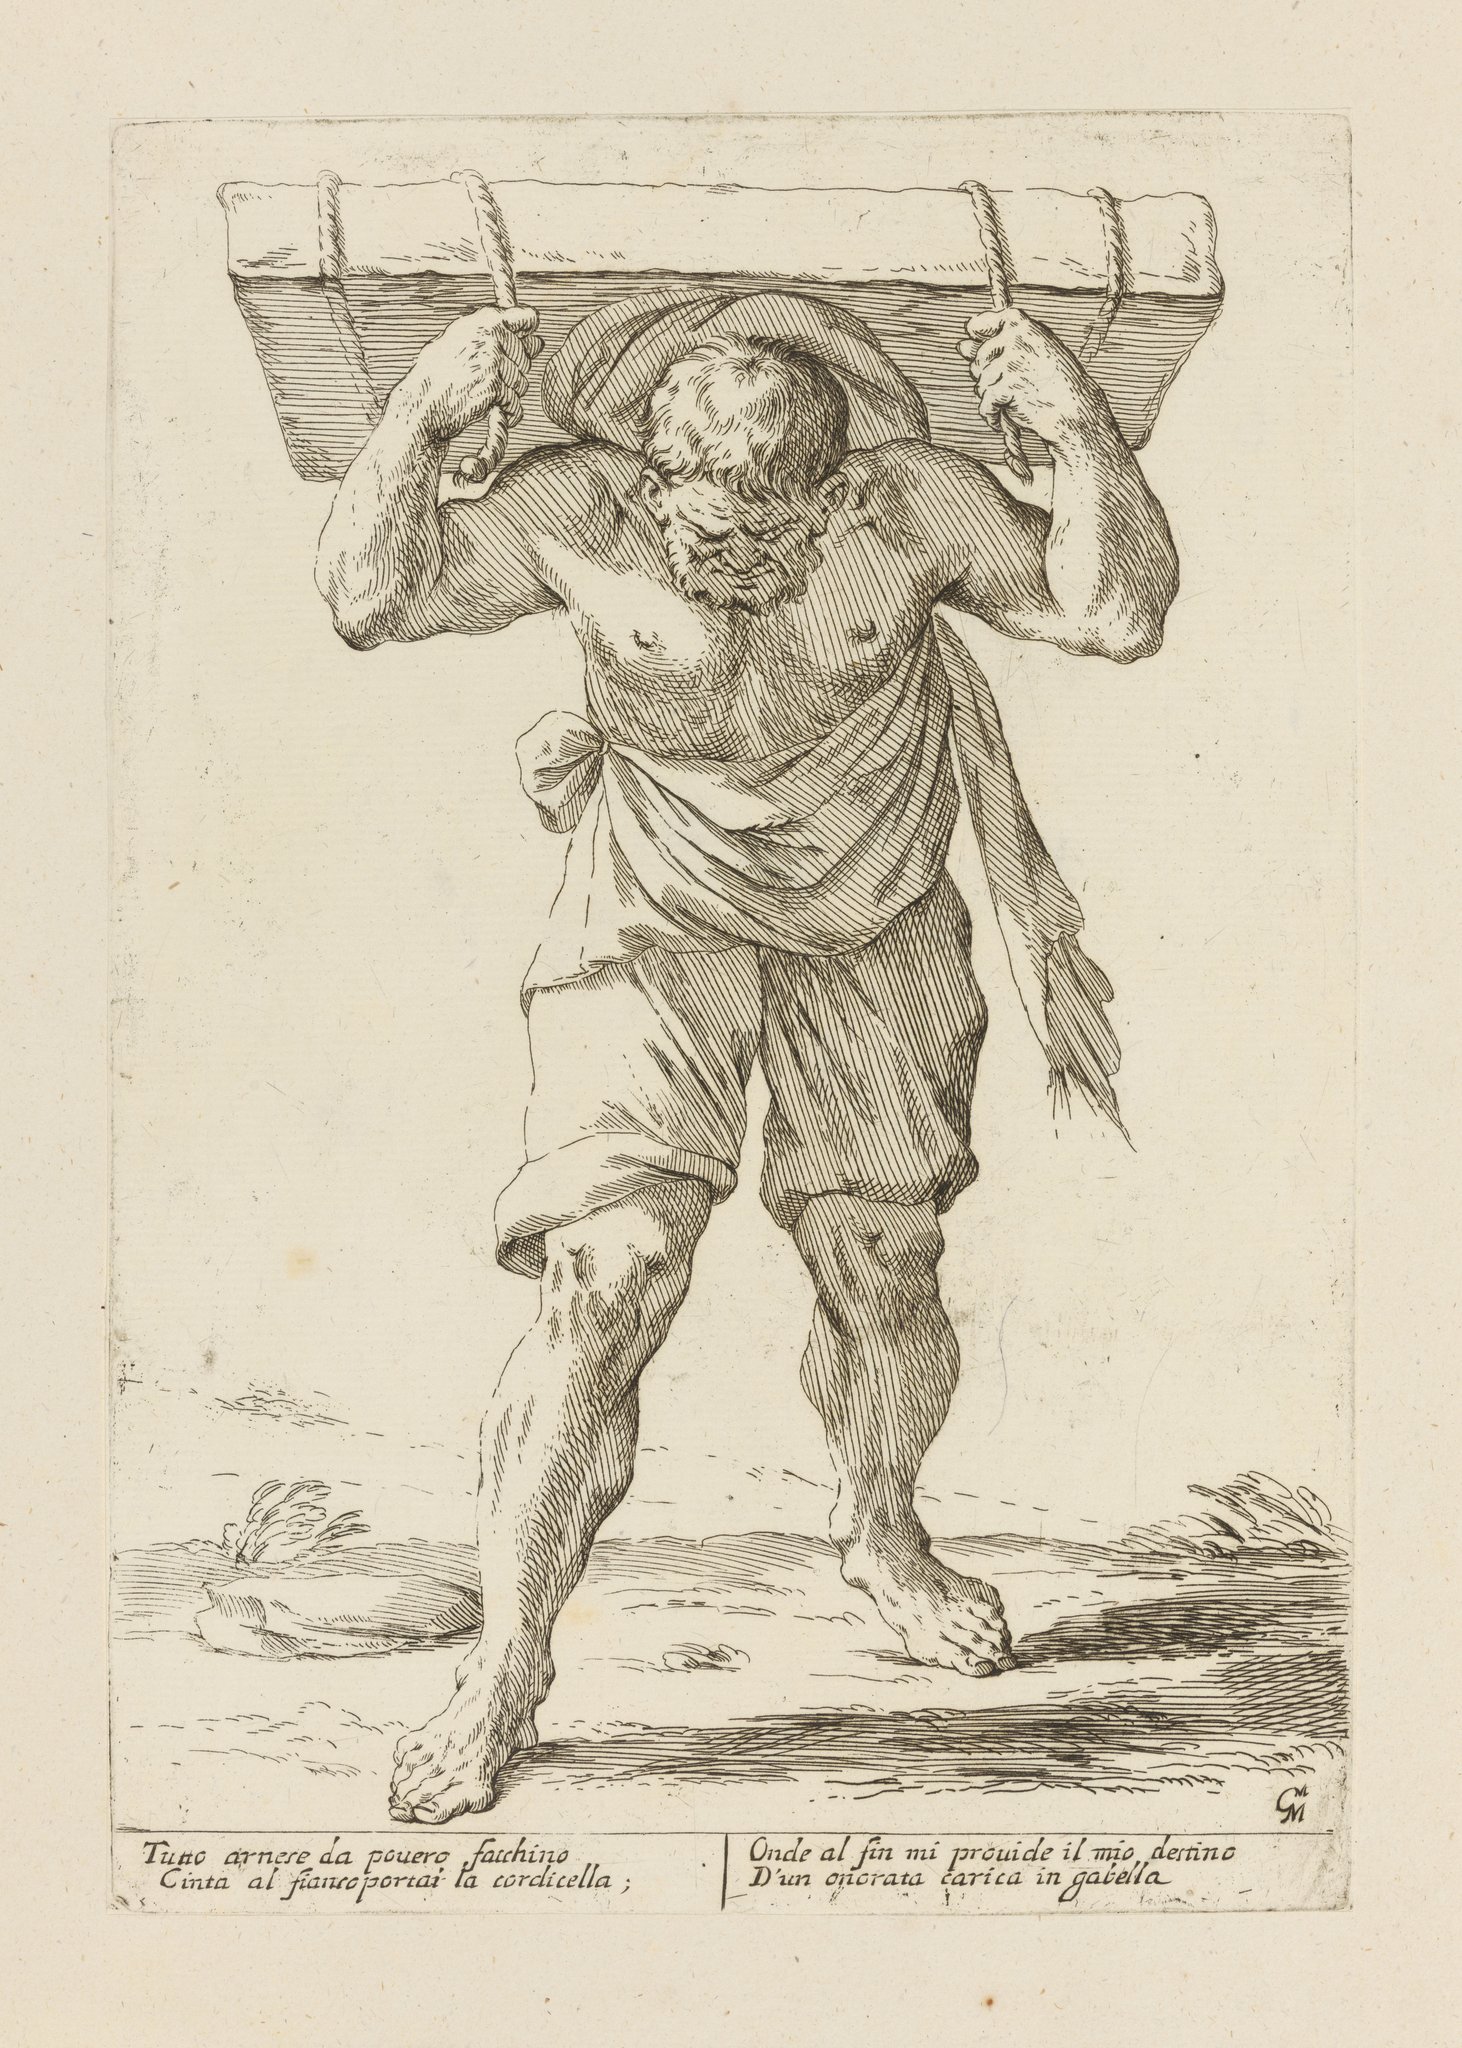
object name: print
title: Porter, from Di Bologna l'Arti per via D'An.ibal' Ca.rac, plate 18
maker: giuseppe maria mitelli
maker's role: artist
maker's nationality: italian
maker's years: 1634-1718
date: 1660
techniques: etching